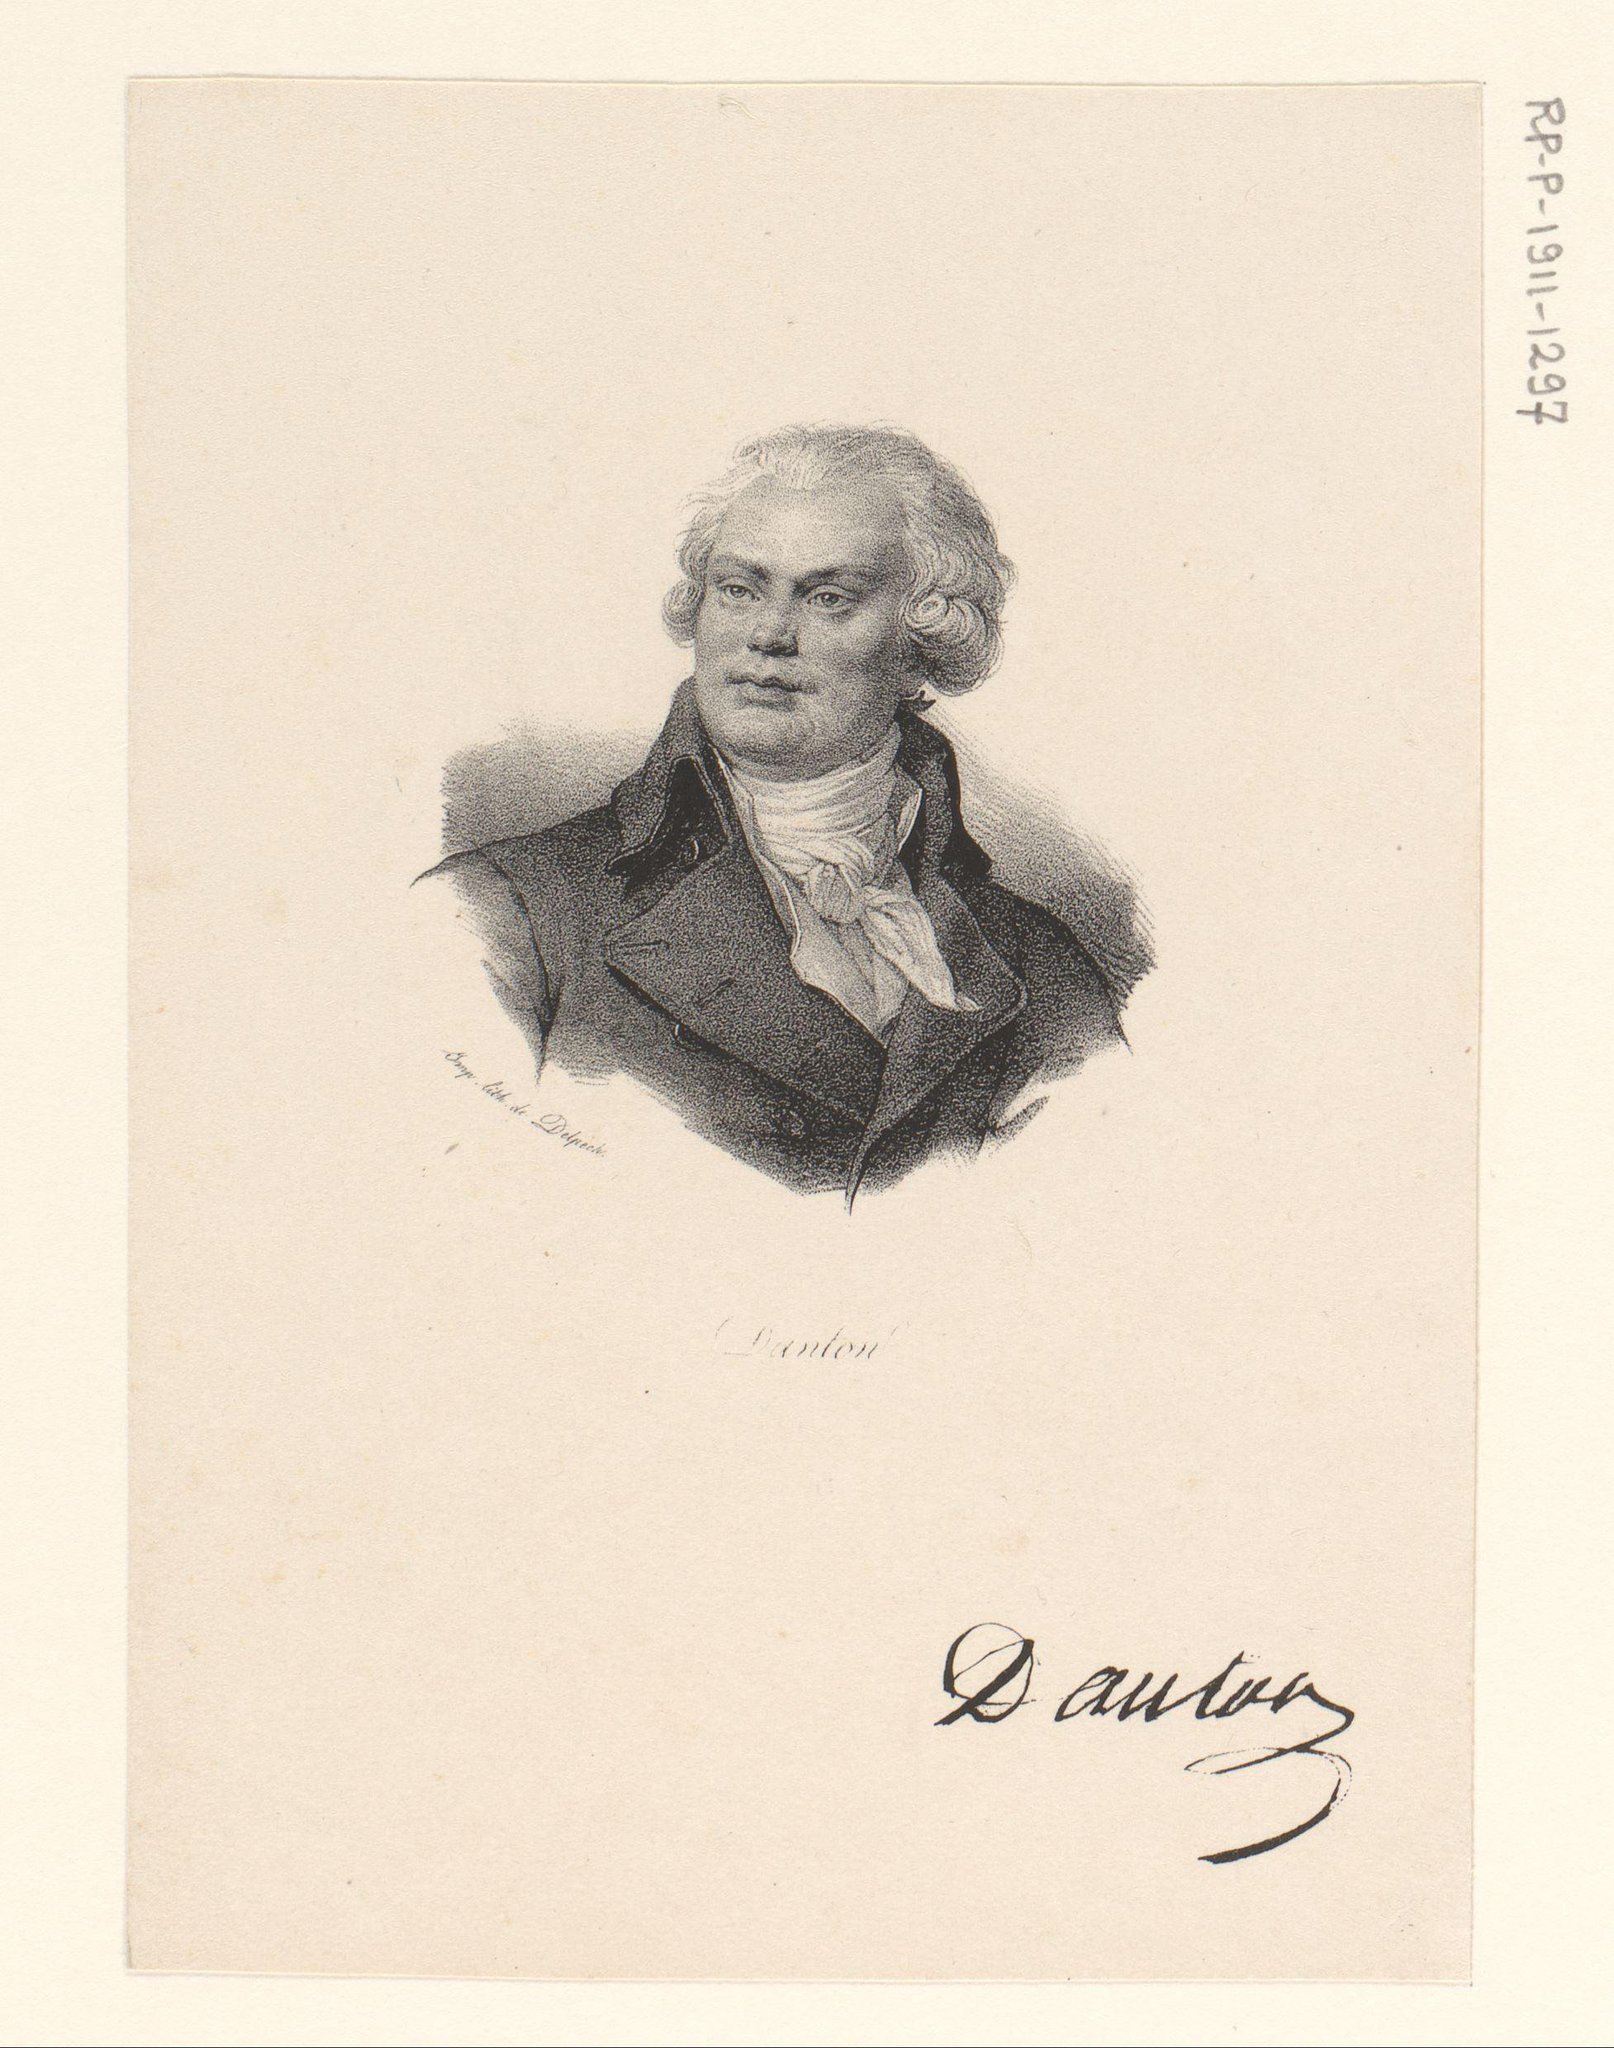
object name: print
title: Portret van Georges Jacques Danton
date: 1818-1842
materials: paper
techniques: lithograph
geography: paris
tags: paris, politician, historical persons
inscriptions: collector's mark: Lugt 2228a